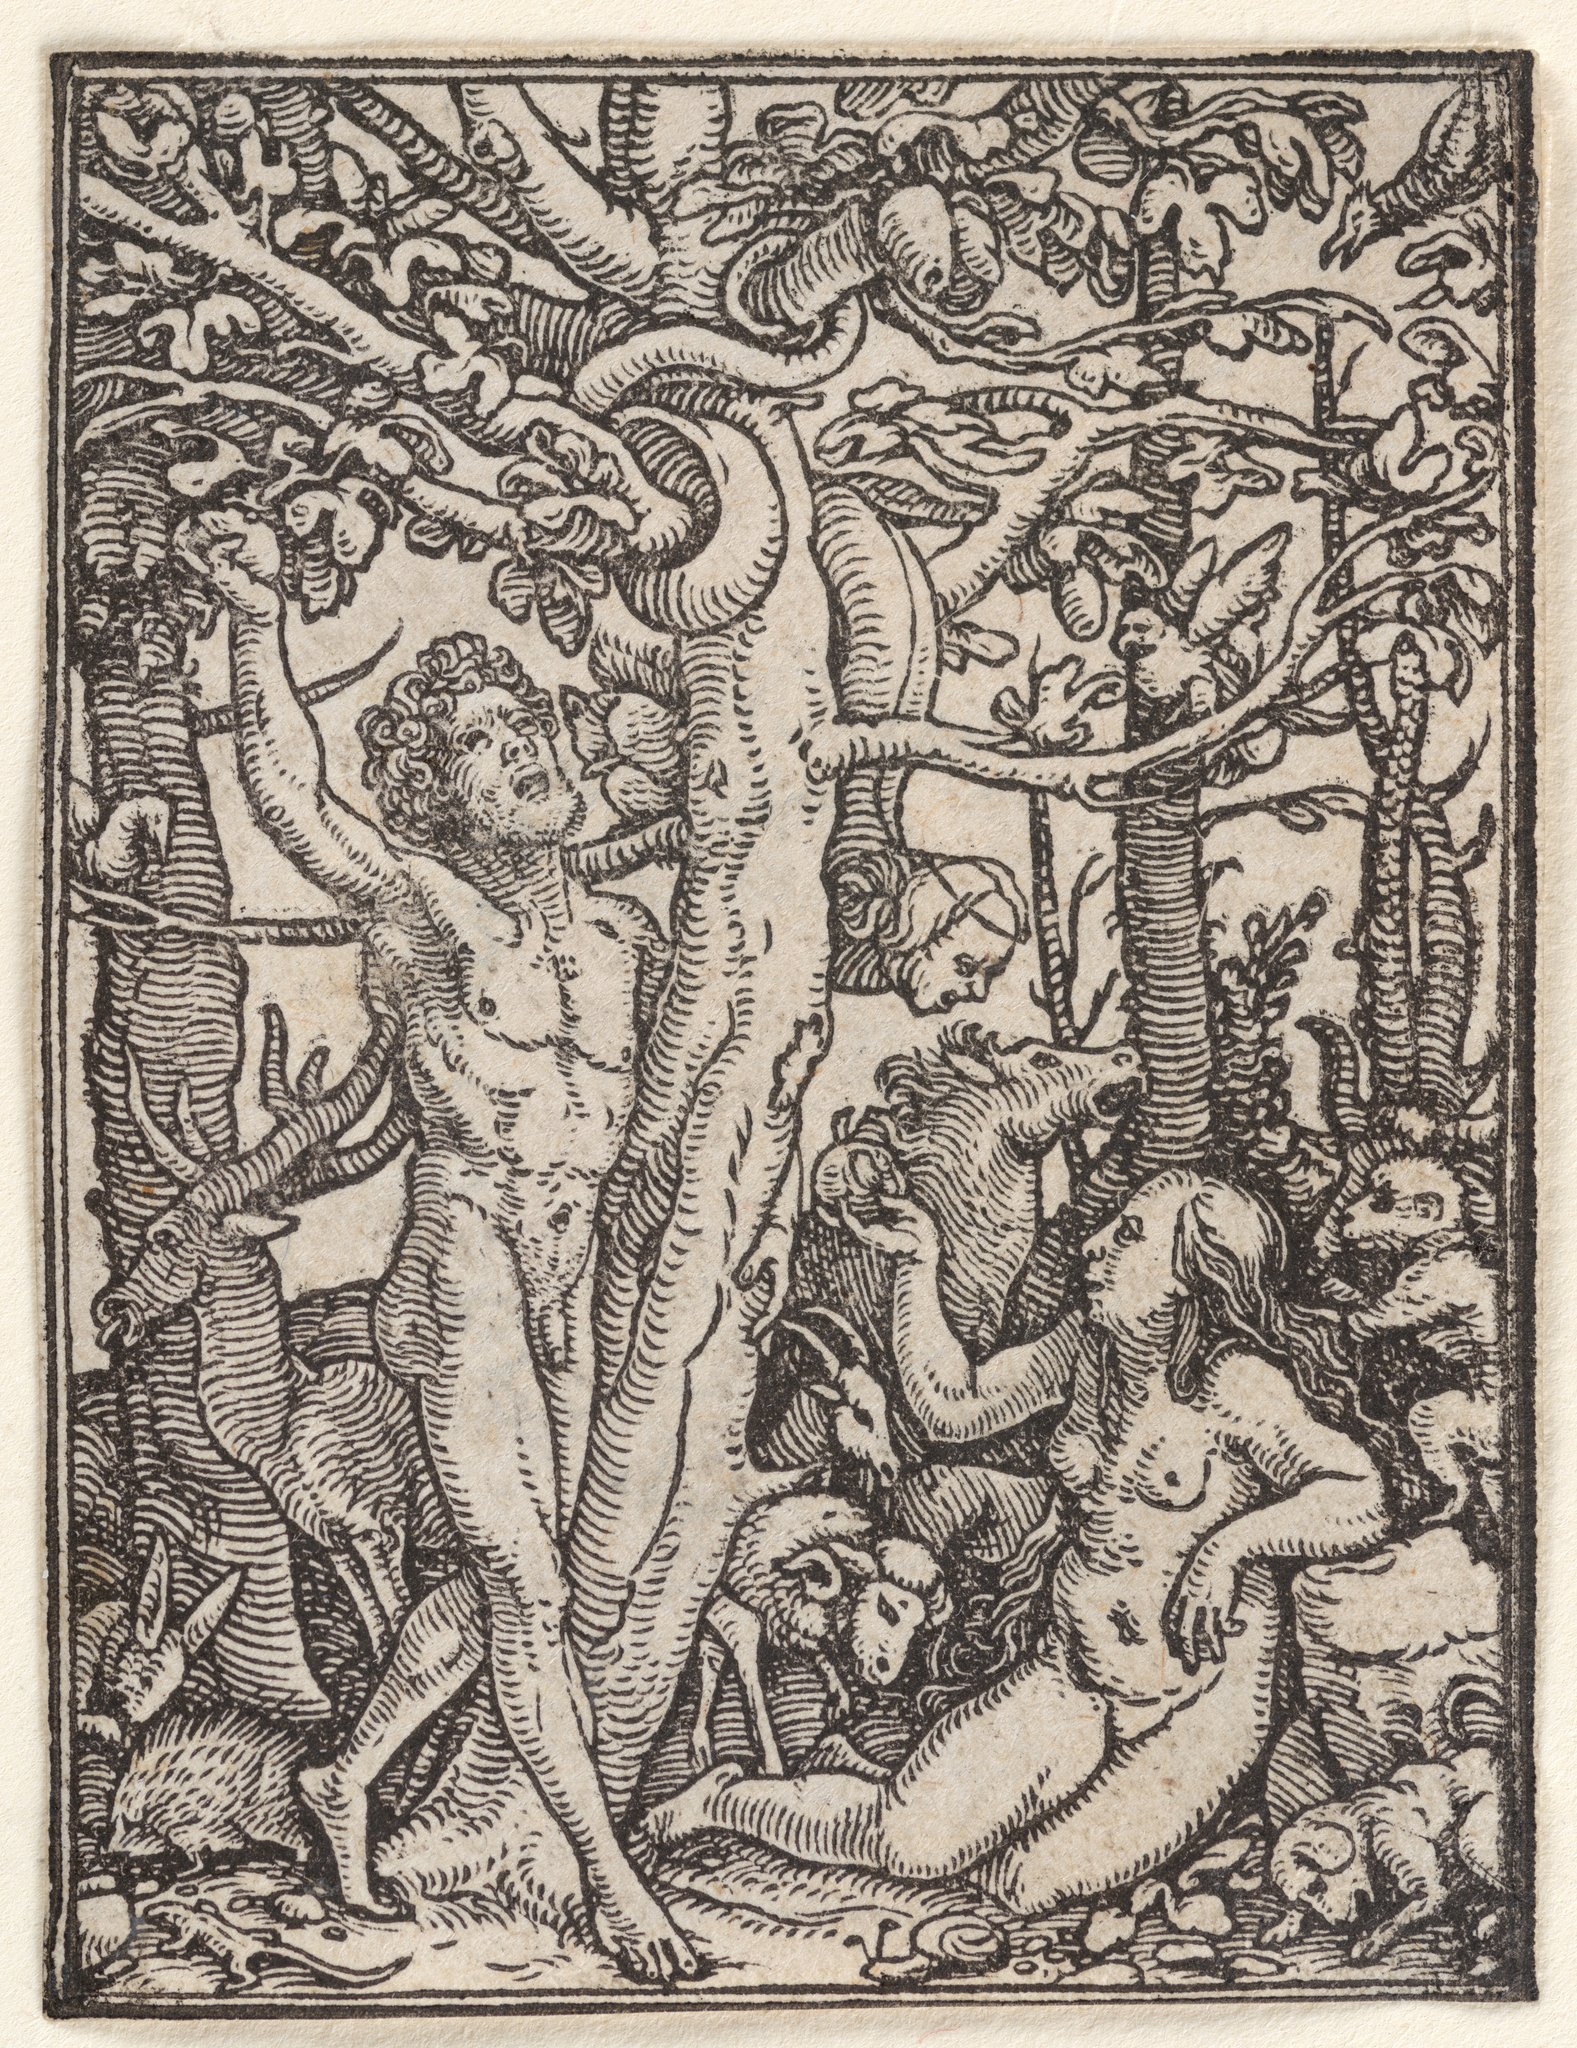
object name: print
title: Fall (or Temptation of Adam), from "The Dance of Death"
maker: hans holbein the younger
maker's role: artist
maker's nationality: german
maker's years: 1497-1543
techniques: woodcut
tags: serpents,adam,eve